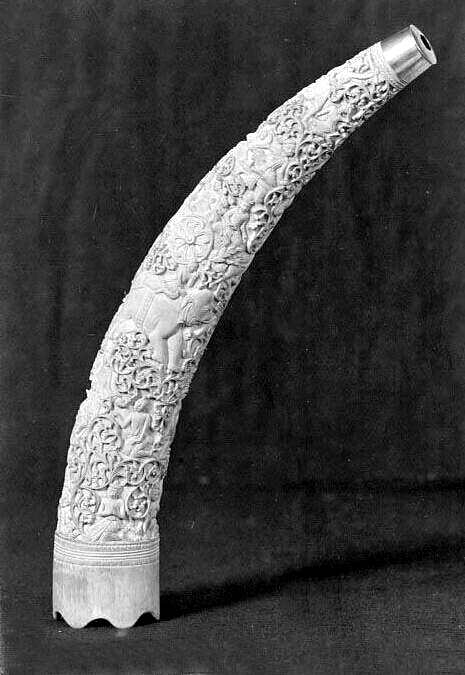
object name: horn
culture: burmese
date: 1867-1900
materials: ivory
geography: myanmar